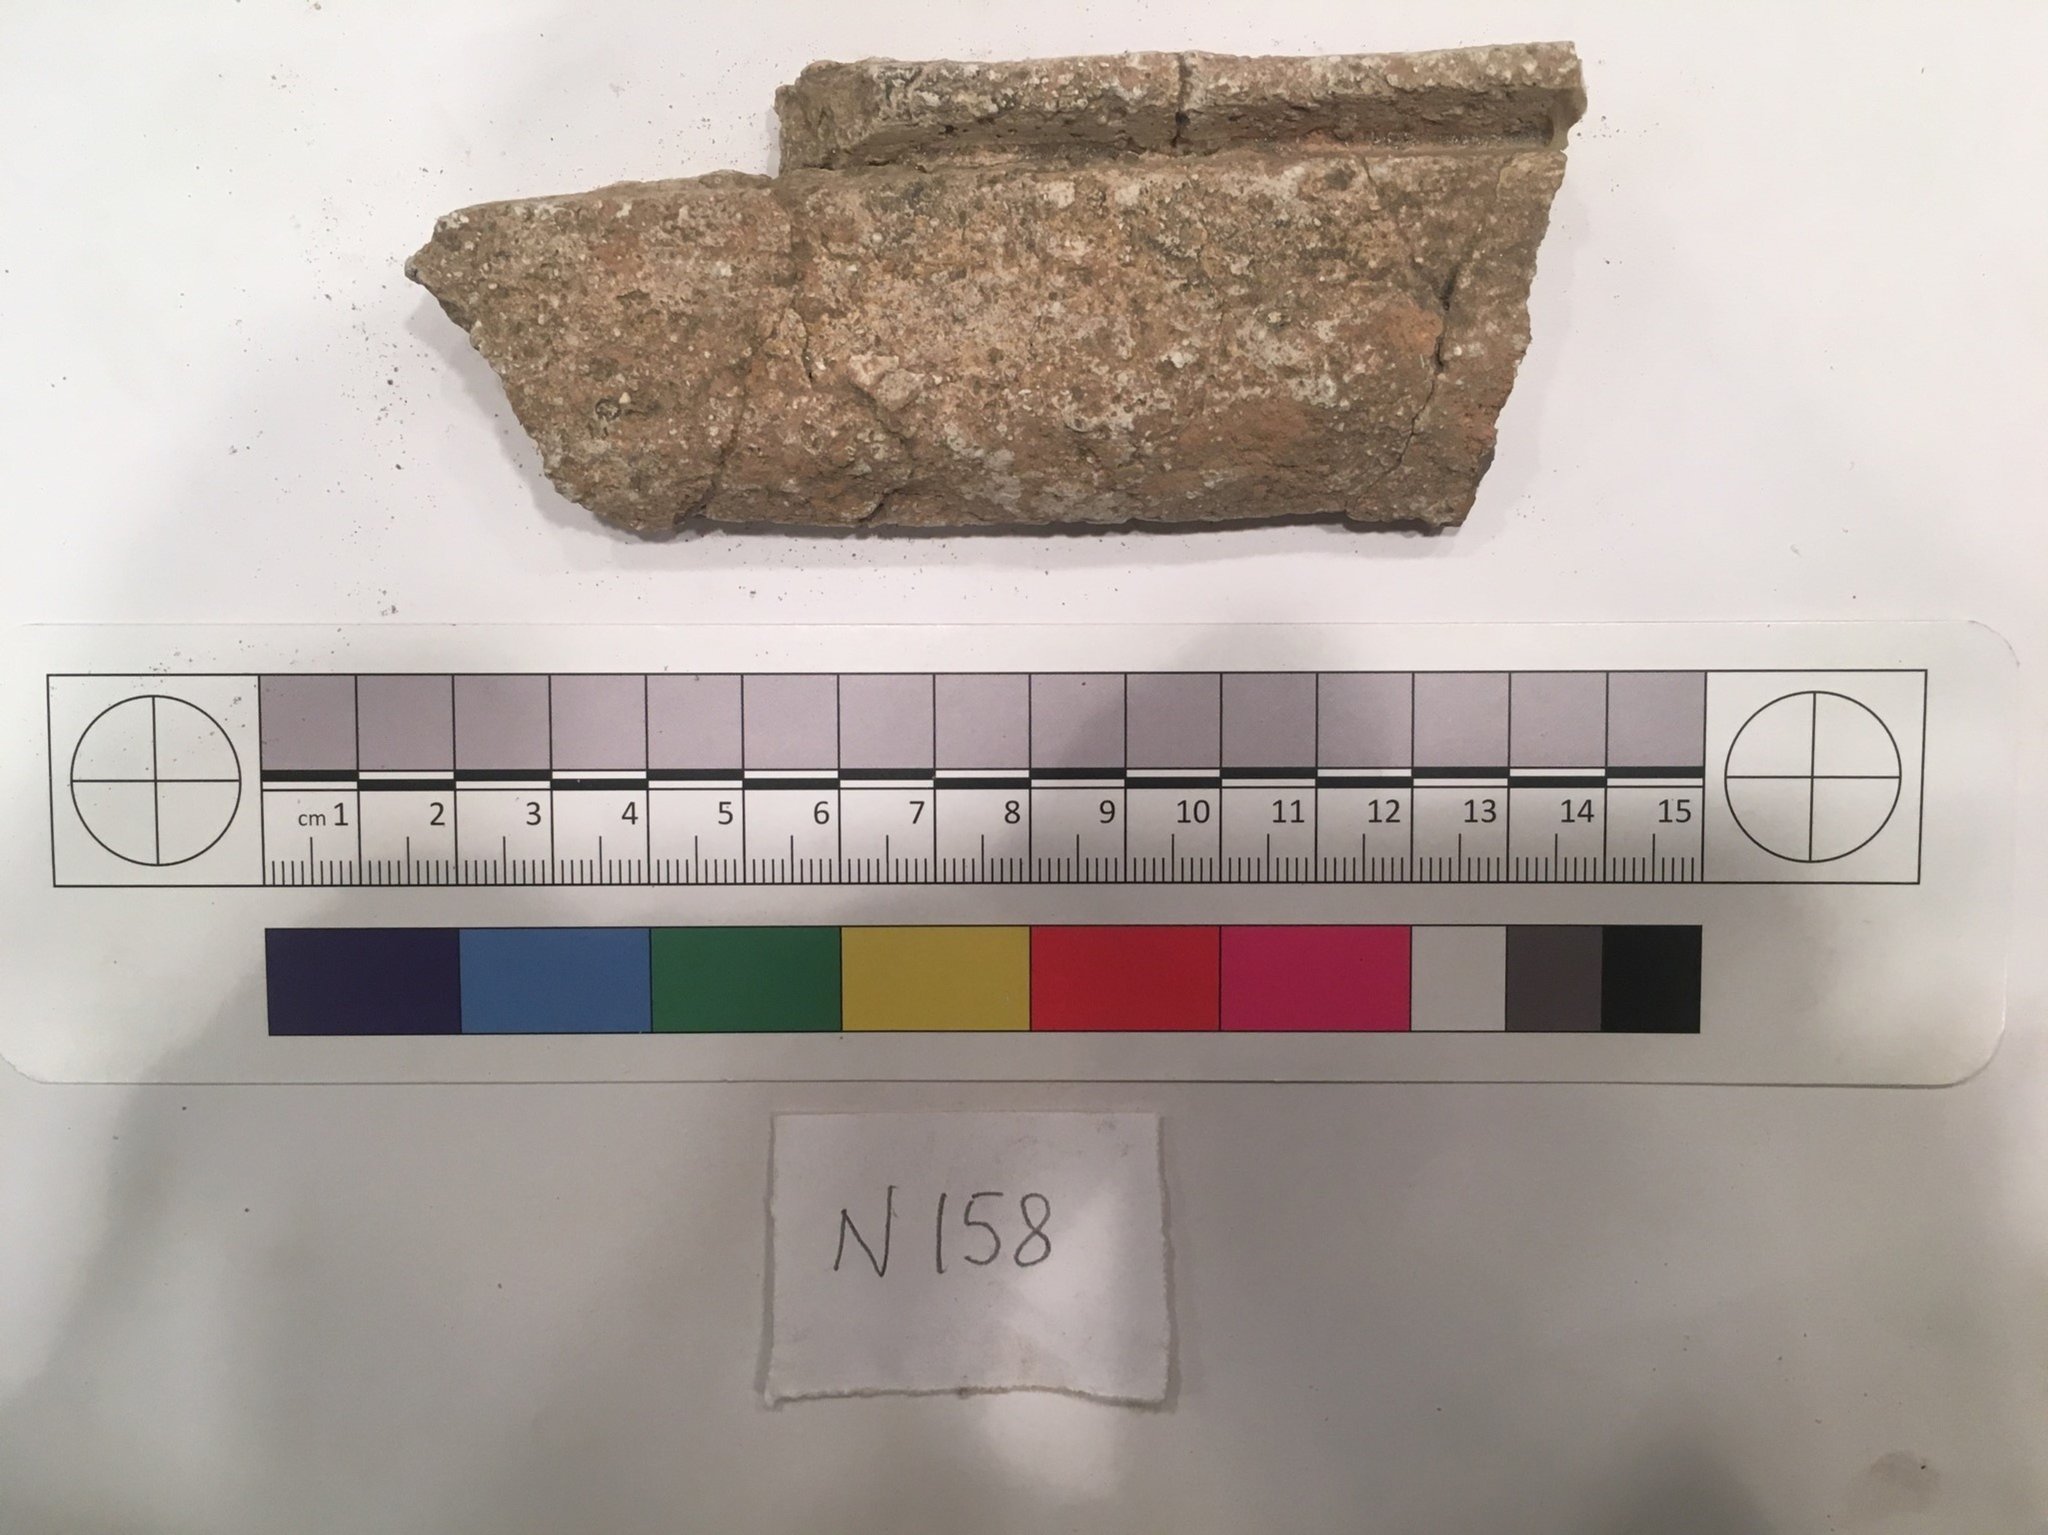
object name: fragment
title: Stucco Fragment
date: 701-1200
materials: plaster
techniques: carving, painting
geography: iran